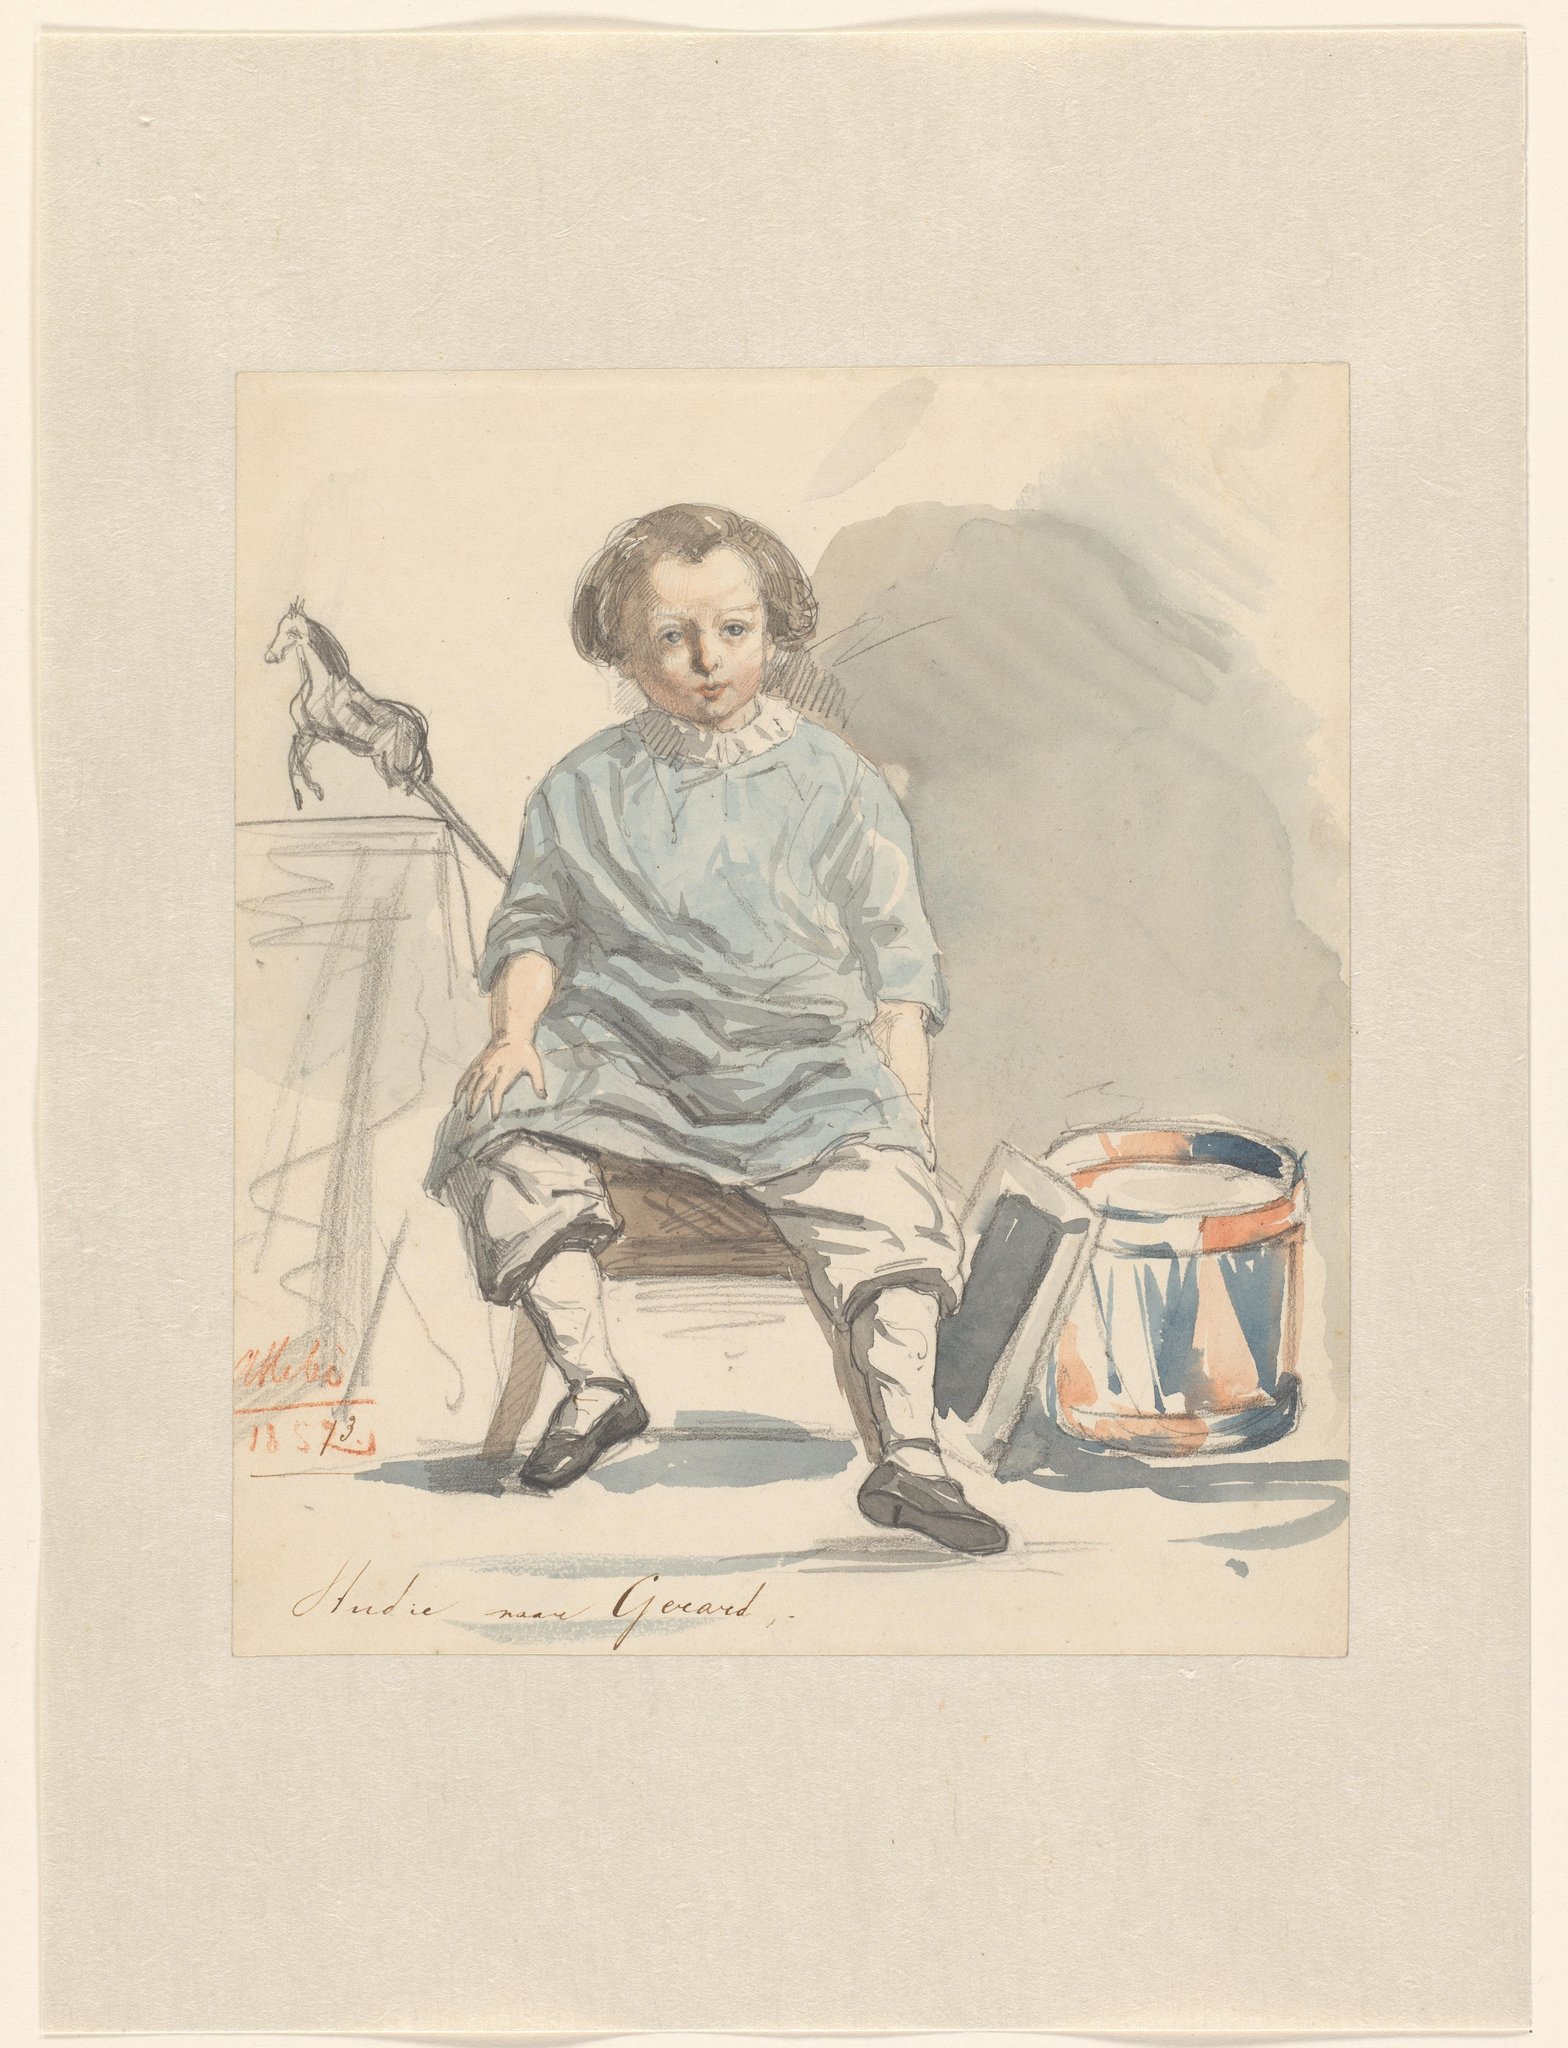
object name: drawing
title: Studie naar Gerard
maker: august allebé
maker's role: draughtsman, print maker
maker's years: 1838-1927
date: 1852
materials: chalk, paper, pencil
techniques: brush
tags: batavia, gerard allebé, historical persons